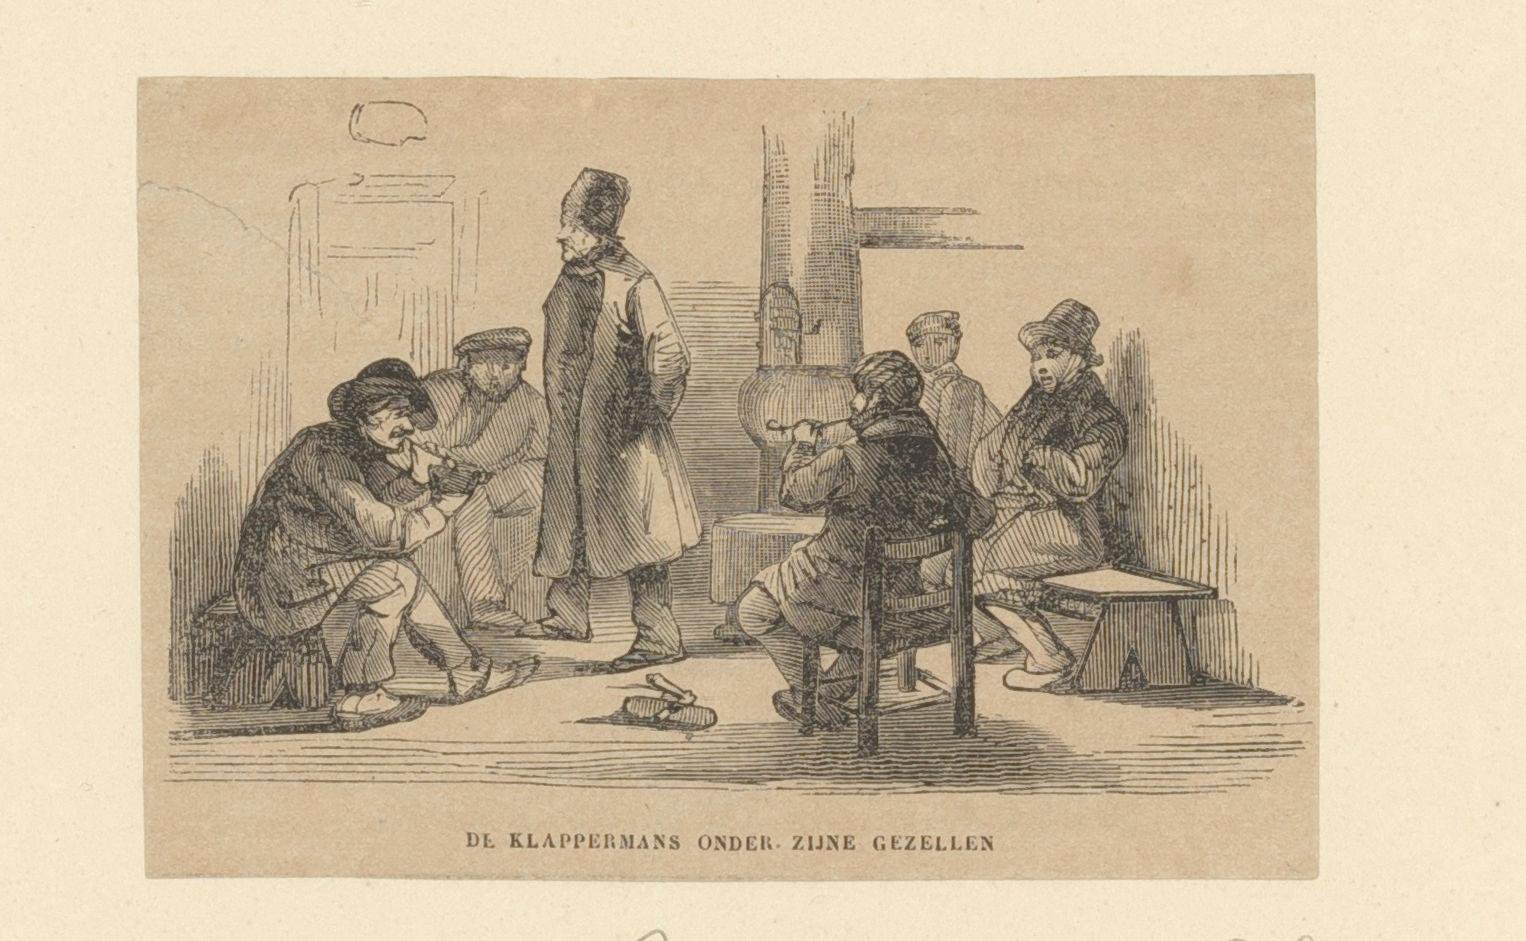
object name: print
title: Klepperman voor of na zijn dienst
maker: Anonymous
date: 1849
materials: paper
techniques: letterpress printing, engraving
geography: amsterdam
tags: guard duty, keeping sentry, night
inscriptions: collector's mark: Lugt 1641, stamp, stamp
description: De klepperman of klapperman is een nachtwacht die in de nacht over straat loopt met een klep en riep om hoe laat het was. Onderwerpsrubrieken binnen de Atlas Zeden en Gewoonten: Handel, Nijverheid en verkeer, Beroep en bedrijf, Mannelijk, Klapperman, omroeper, nachtwaker.